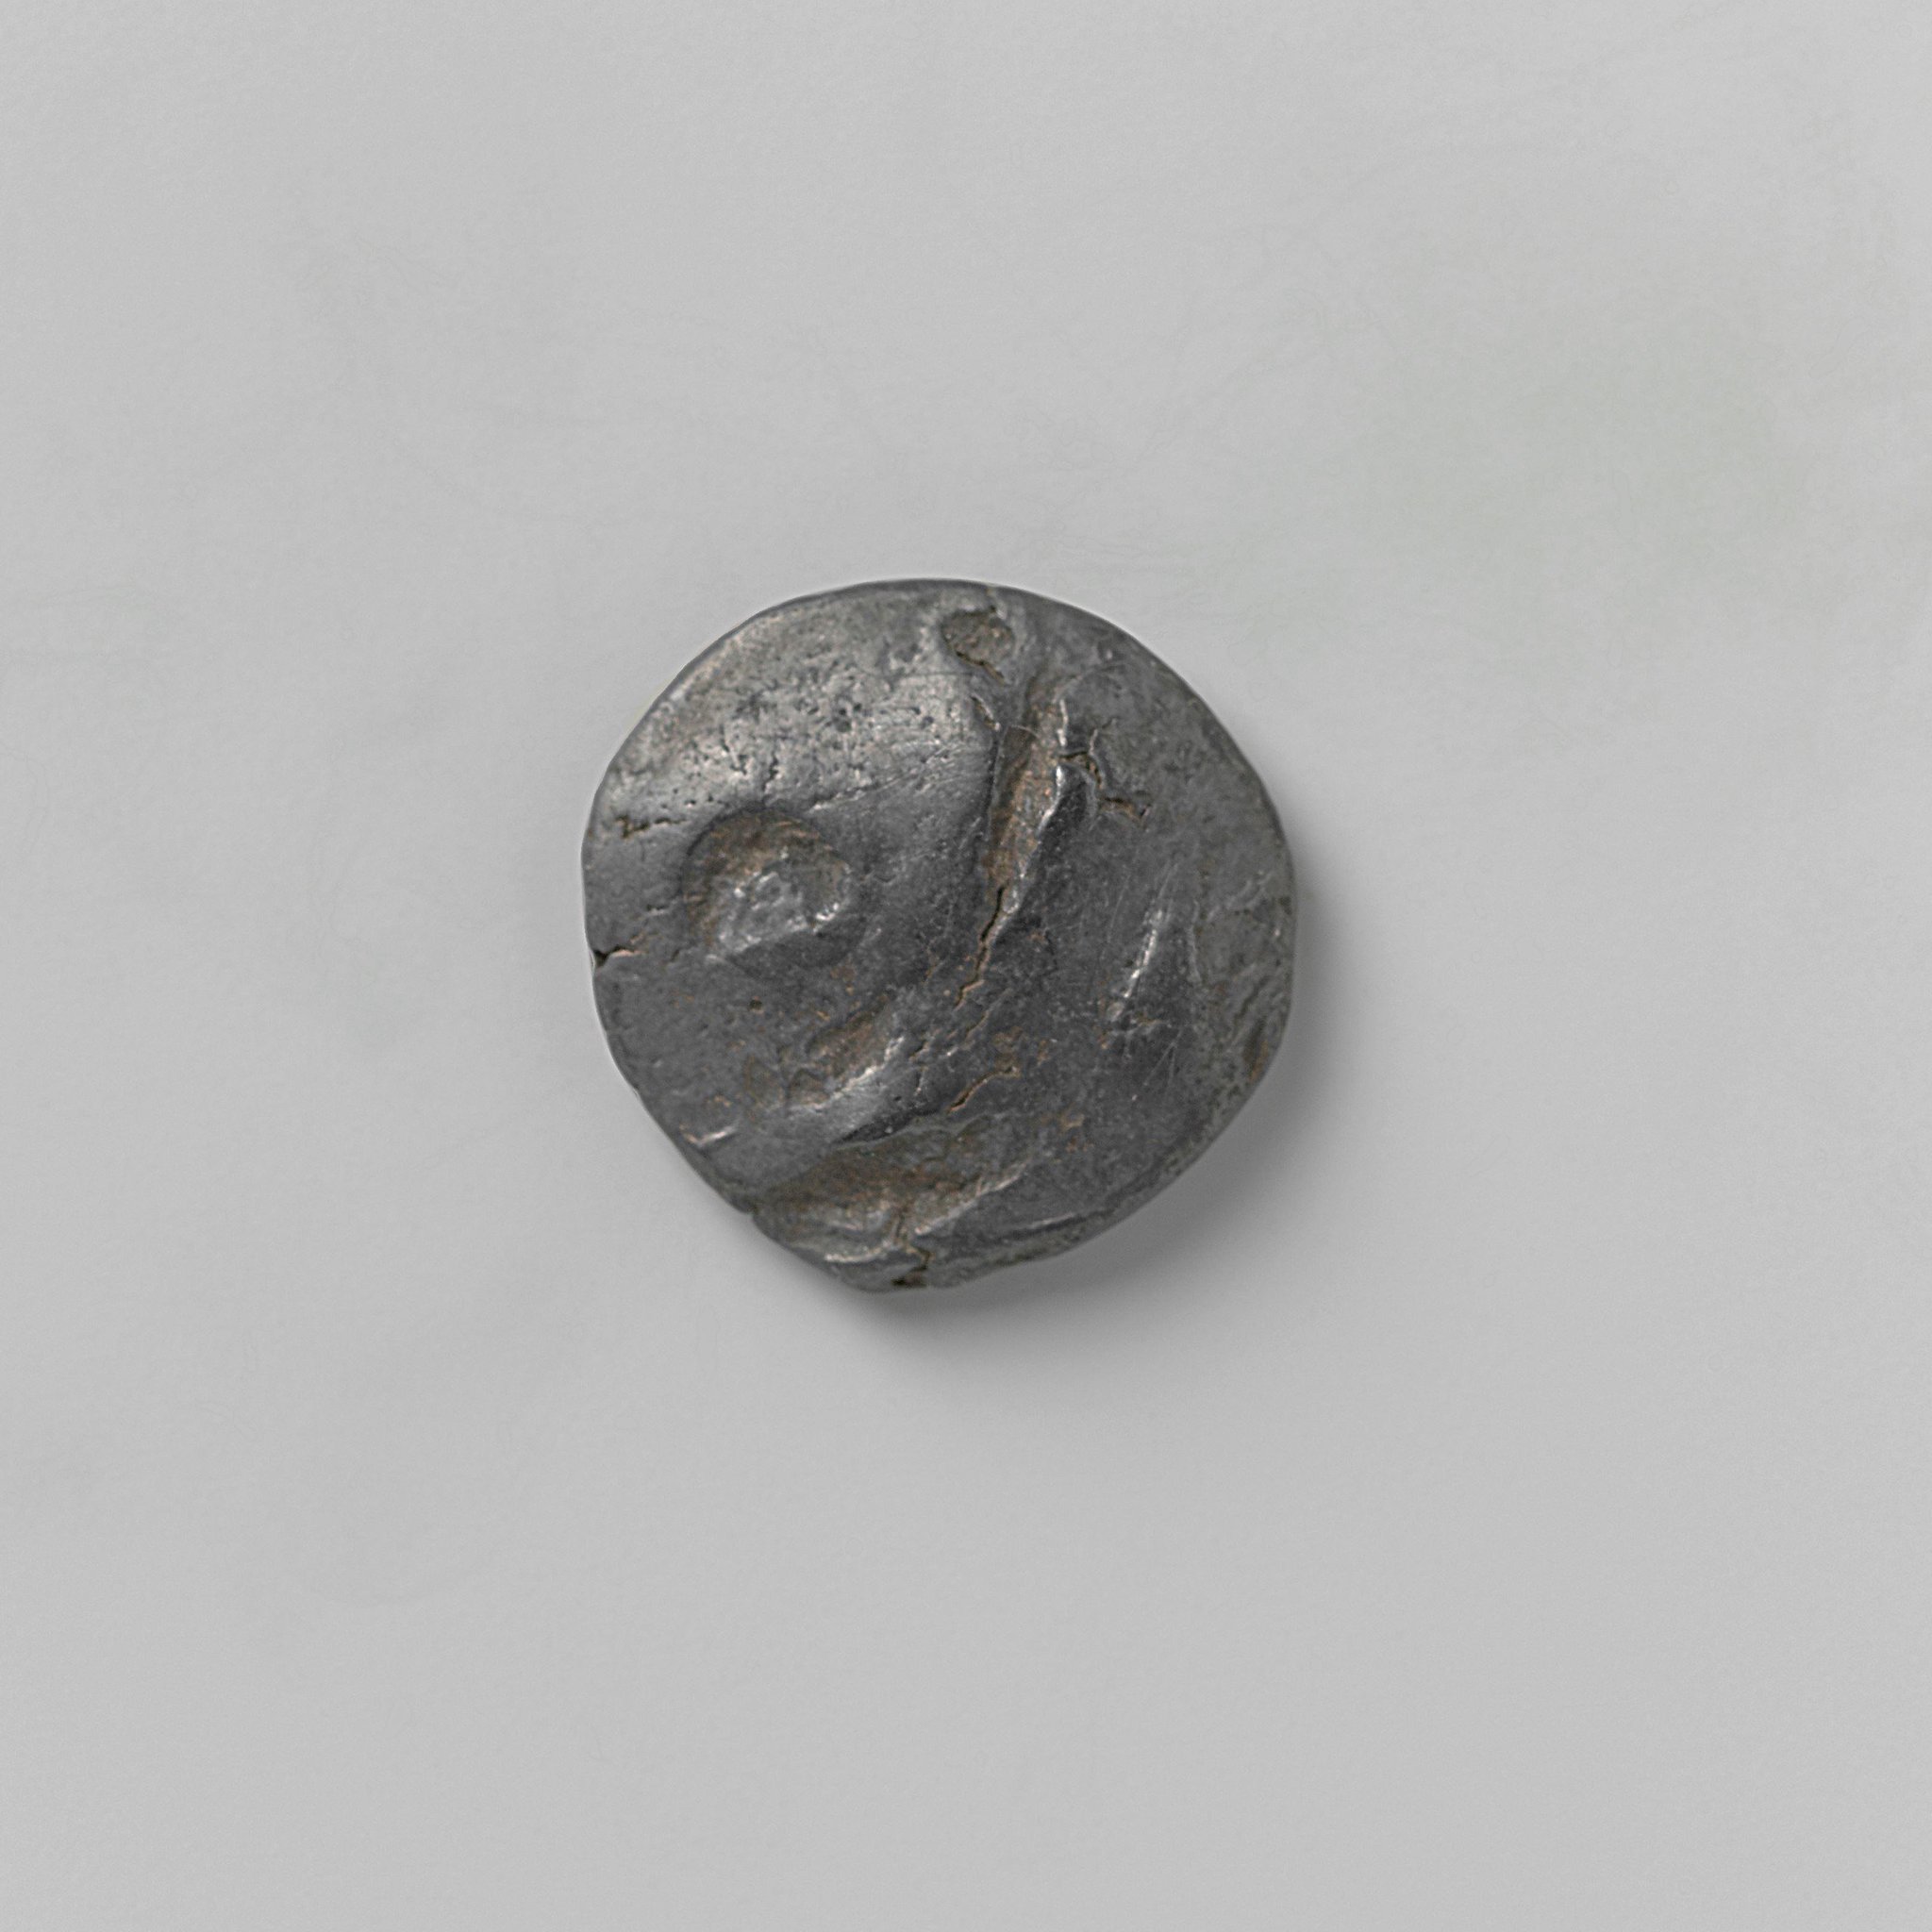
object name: coin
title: Halve djampel van koninkrijk Majopahit op Java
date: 1290-1520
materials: silver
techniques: striking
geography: java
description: Zilveren schotelvormige munt. Voorzijde: letterteken in devanagari-schrift [maa?]. Keerzijde, figuratie [bloem?].